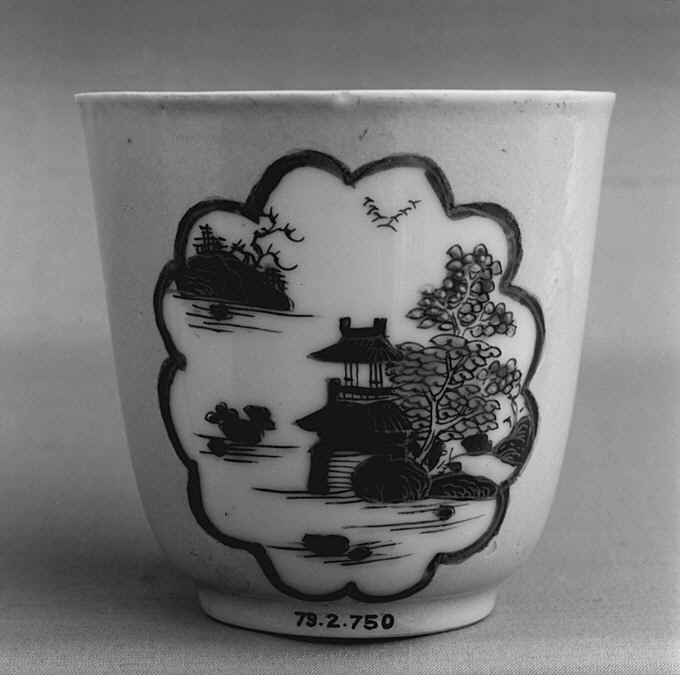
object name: beaker and saucer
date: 1801-1900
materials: hard paste porcelain